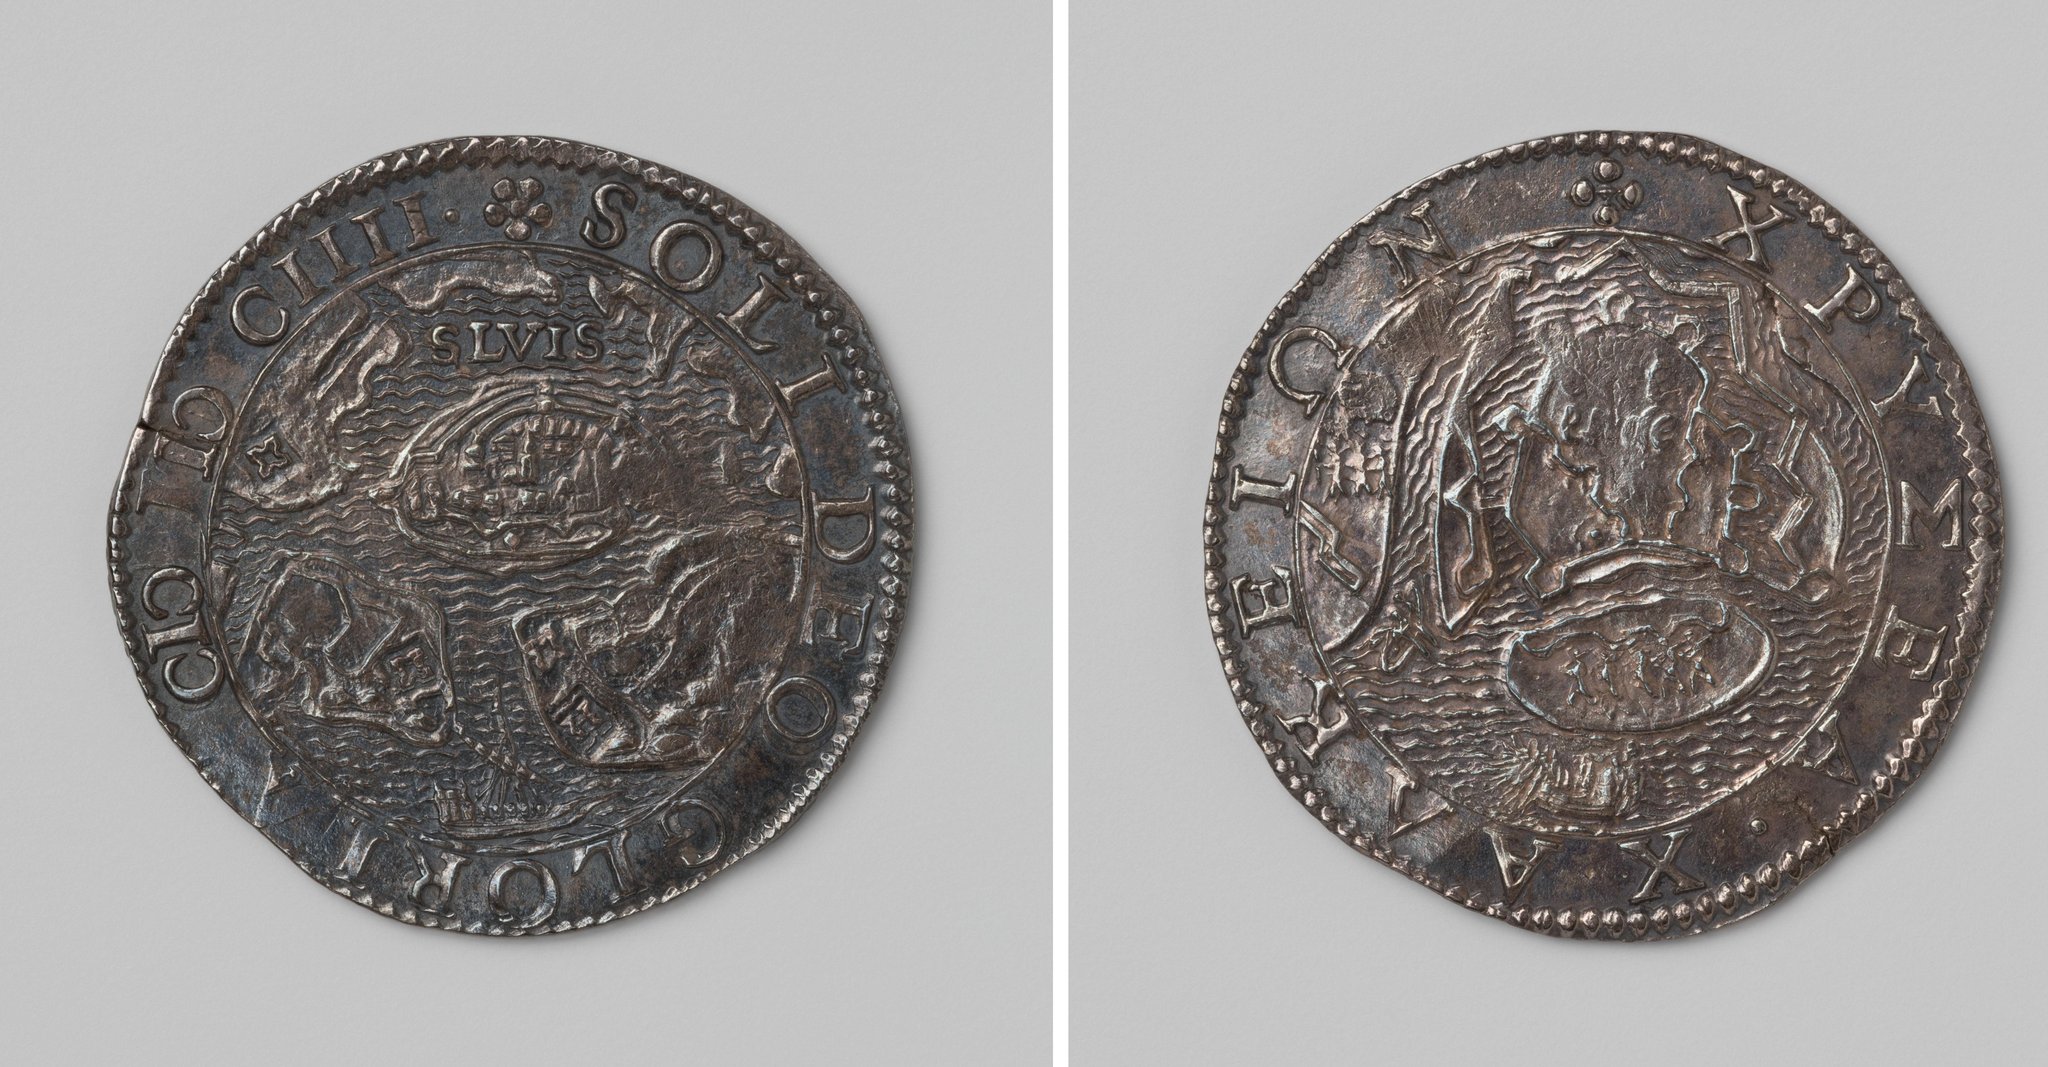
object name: jeton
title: Overgave van Oostende en inname van Sluis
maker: Anonymous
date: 1604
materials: silver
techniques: striking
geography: dordrecht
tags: sluis, oostende, overgave van oostende (1604), tachtigjarige oorlog, beleg en inname van sluis (1604)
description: Zilveren penning. Voorzijde: plattegrond van de stad Sluis onder opschrift binnen omschrift. Keerzijde: plattegrond van Oostende binnen omschrift in Grieks schrift